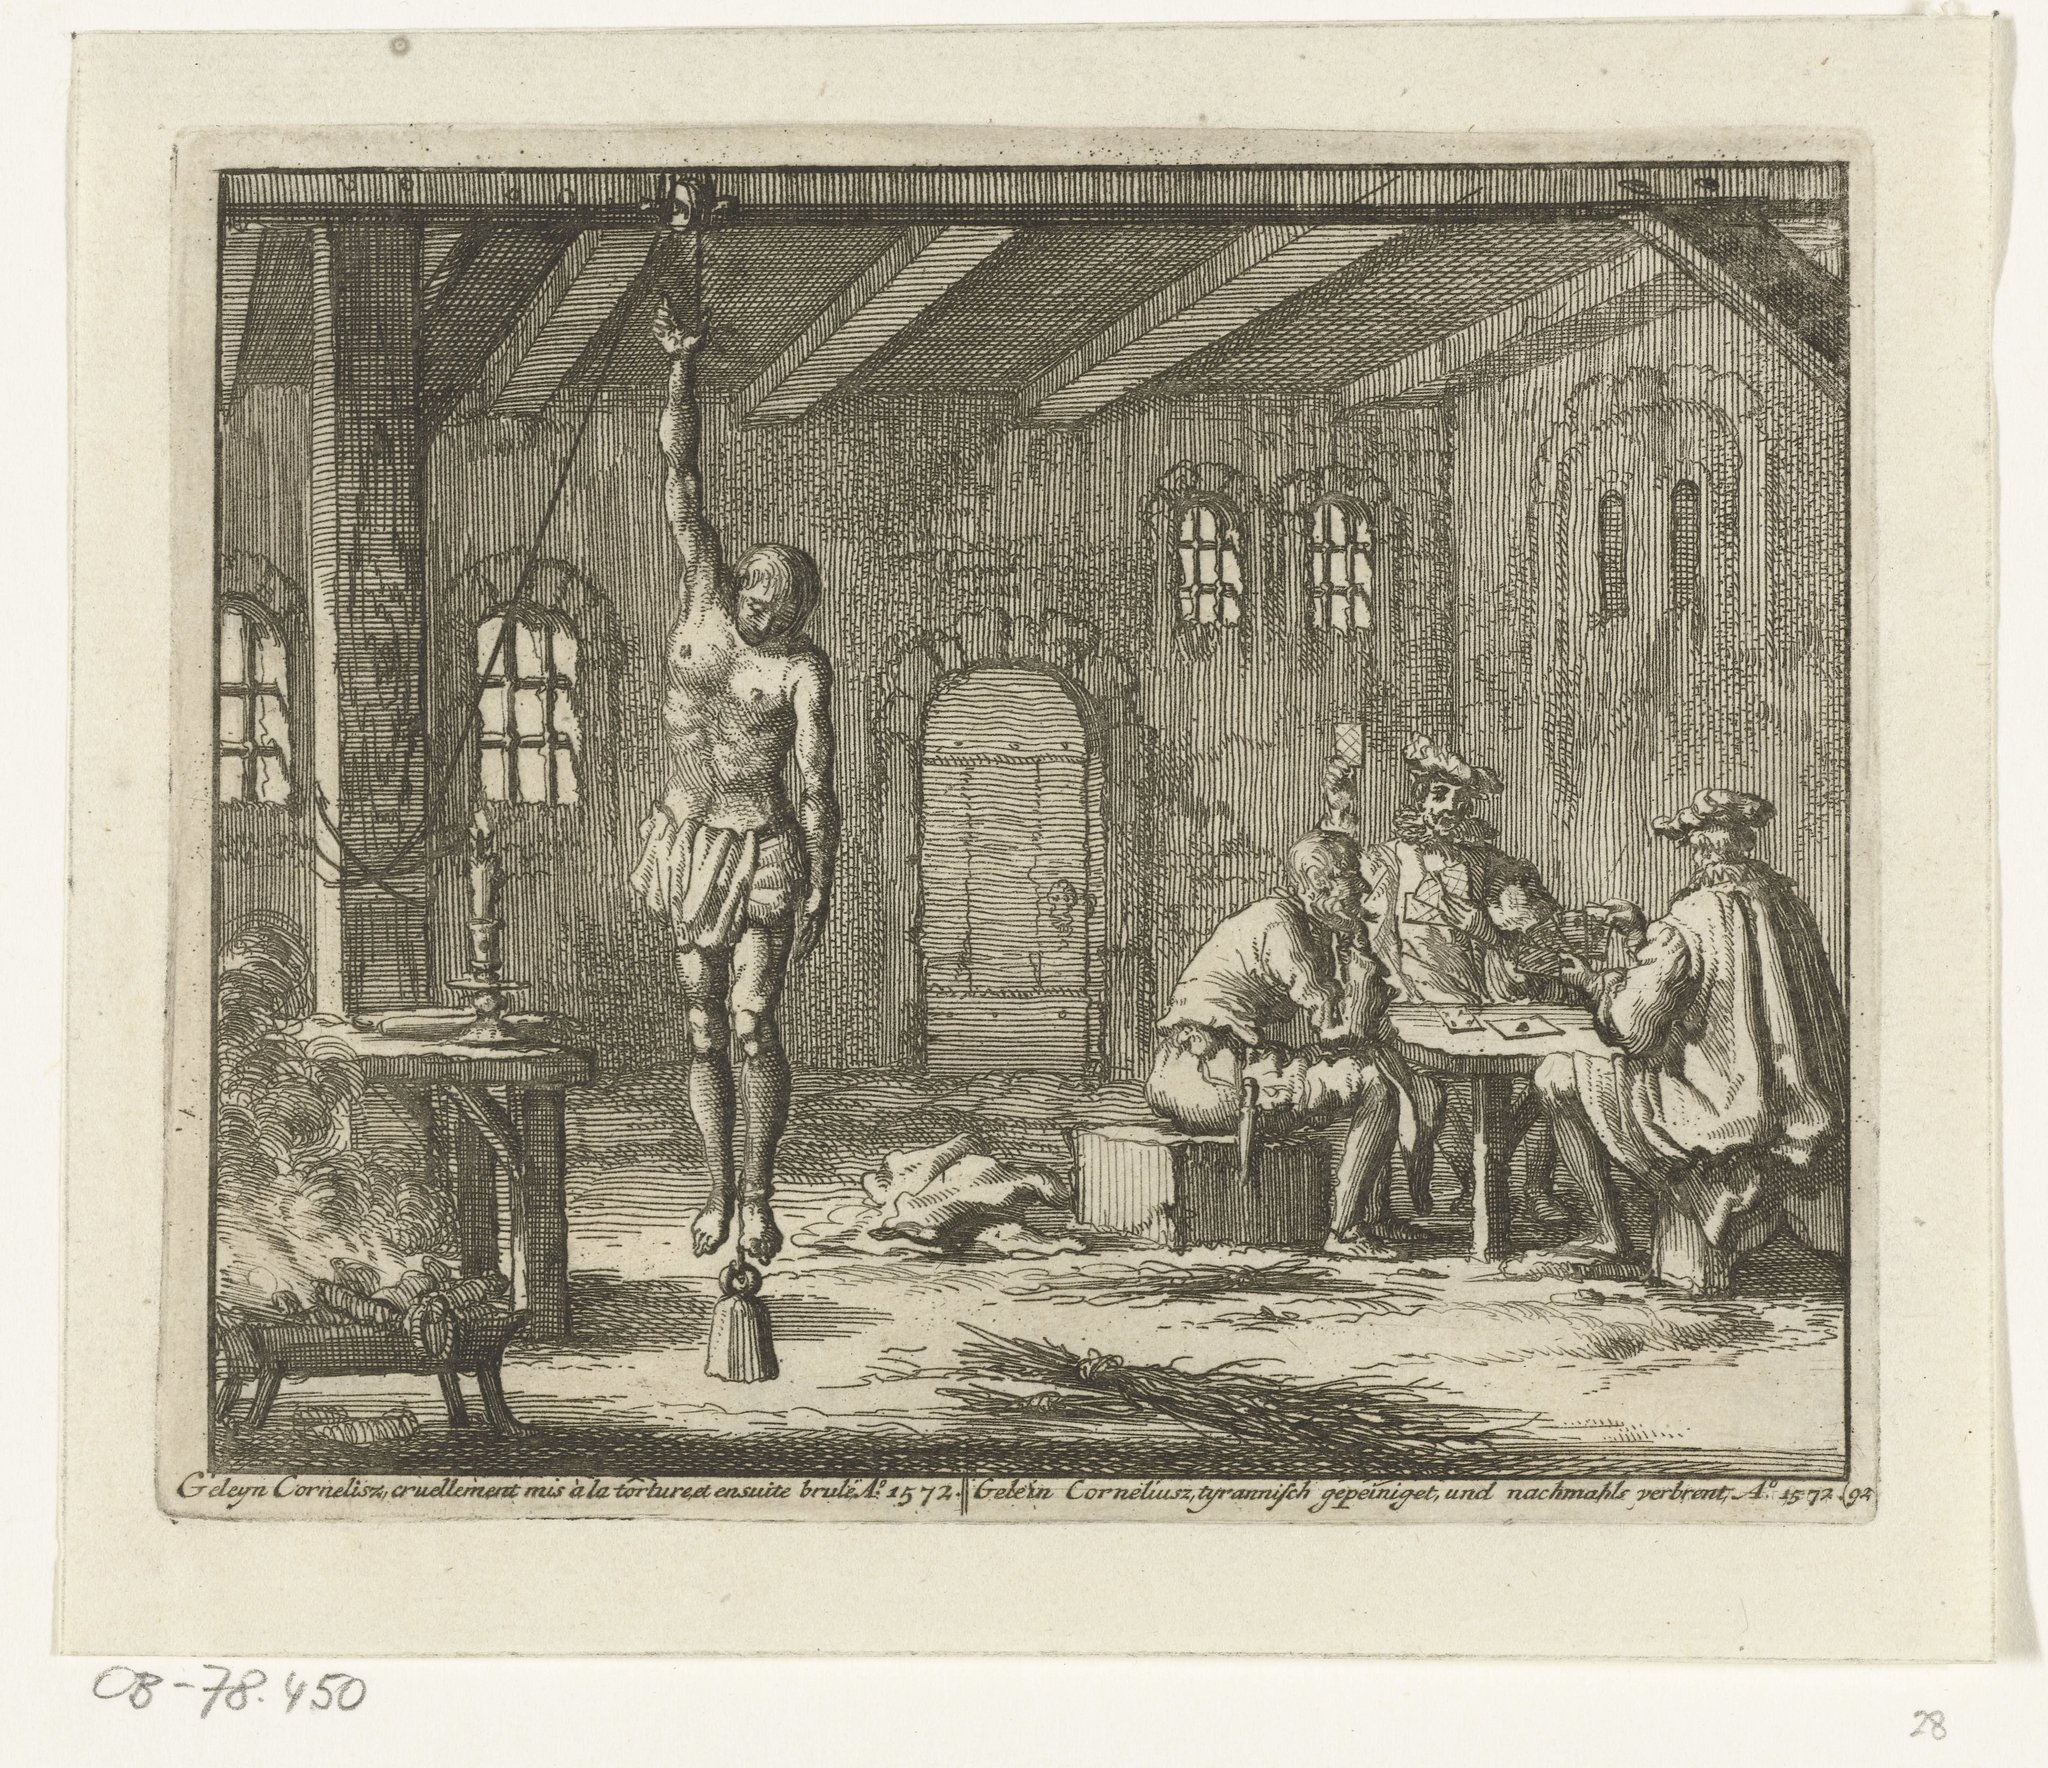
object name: history print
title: Geleyn Cornelisz. te Breda in de gevangenis gepijnigd, 1572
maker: jan luyken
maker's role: draughtsman, print maker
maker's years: 1649-1712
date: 1683-1685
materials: paper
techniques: etching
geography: northern netherlands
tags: execution of heretic, e.g. by burning at the stake, 'auto-da-fé', torture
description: De prenten in deze tweede staat gebruikt als illustratie voor: Theatre des martyrs, depuis la mort de J. Christ jusqu'à present (...). = Schau-buhne der Martyrer, P. van der Aa, Leiden ca. 1715, nr. 92. De prenten zijn oorspronkelijk vervaardigd voor en eerst gebruikt in: T.J. van Bragt, Het bloedig tooneel, of Martelaers spiegel der doops-gesinde of weereloose christenen, 1685.